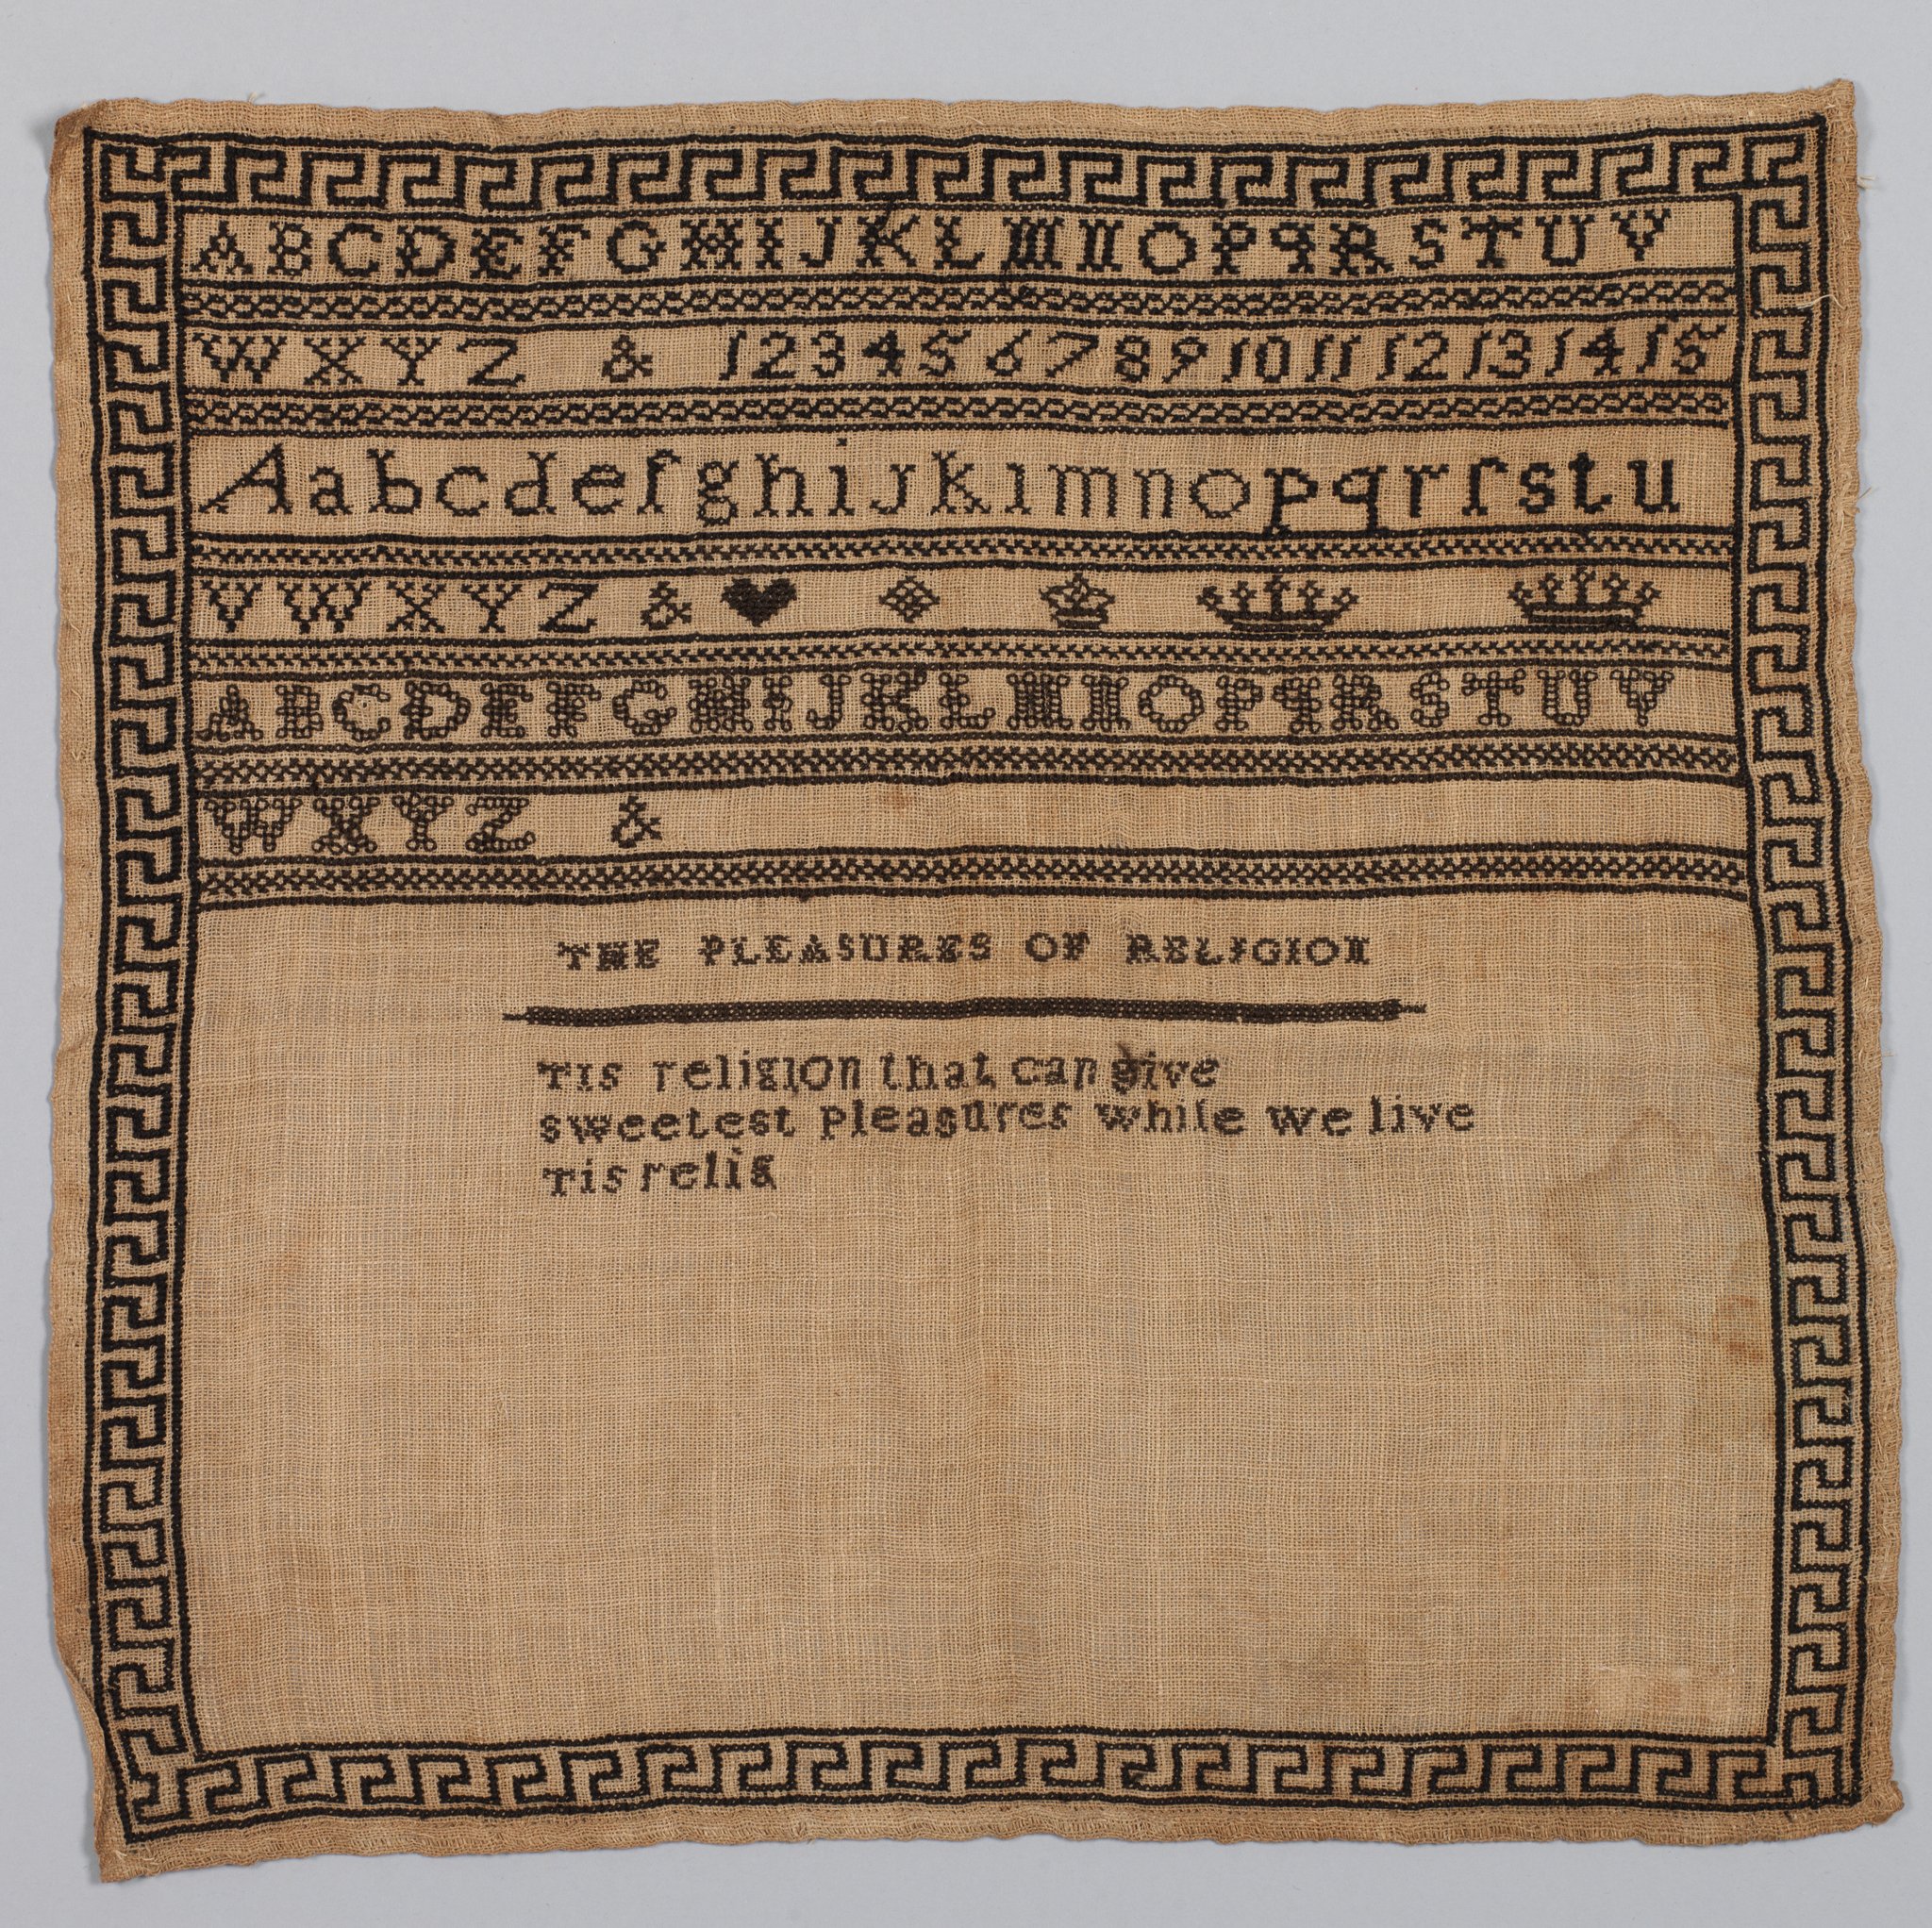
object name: sampler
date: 1801-1833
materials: canvas, linen, silk